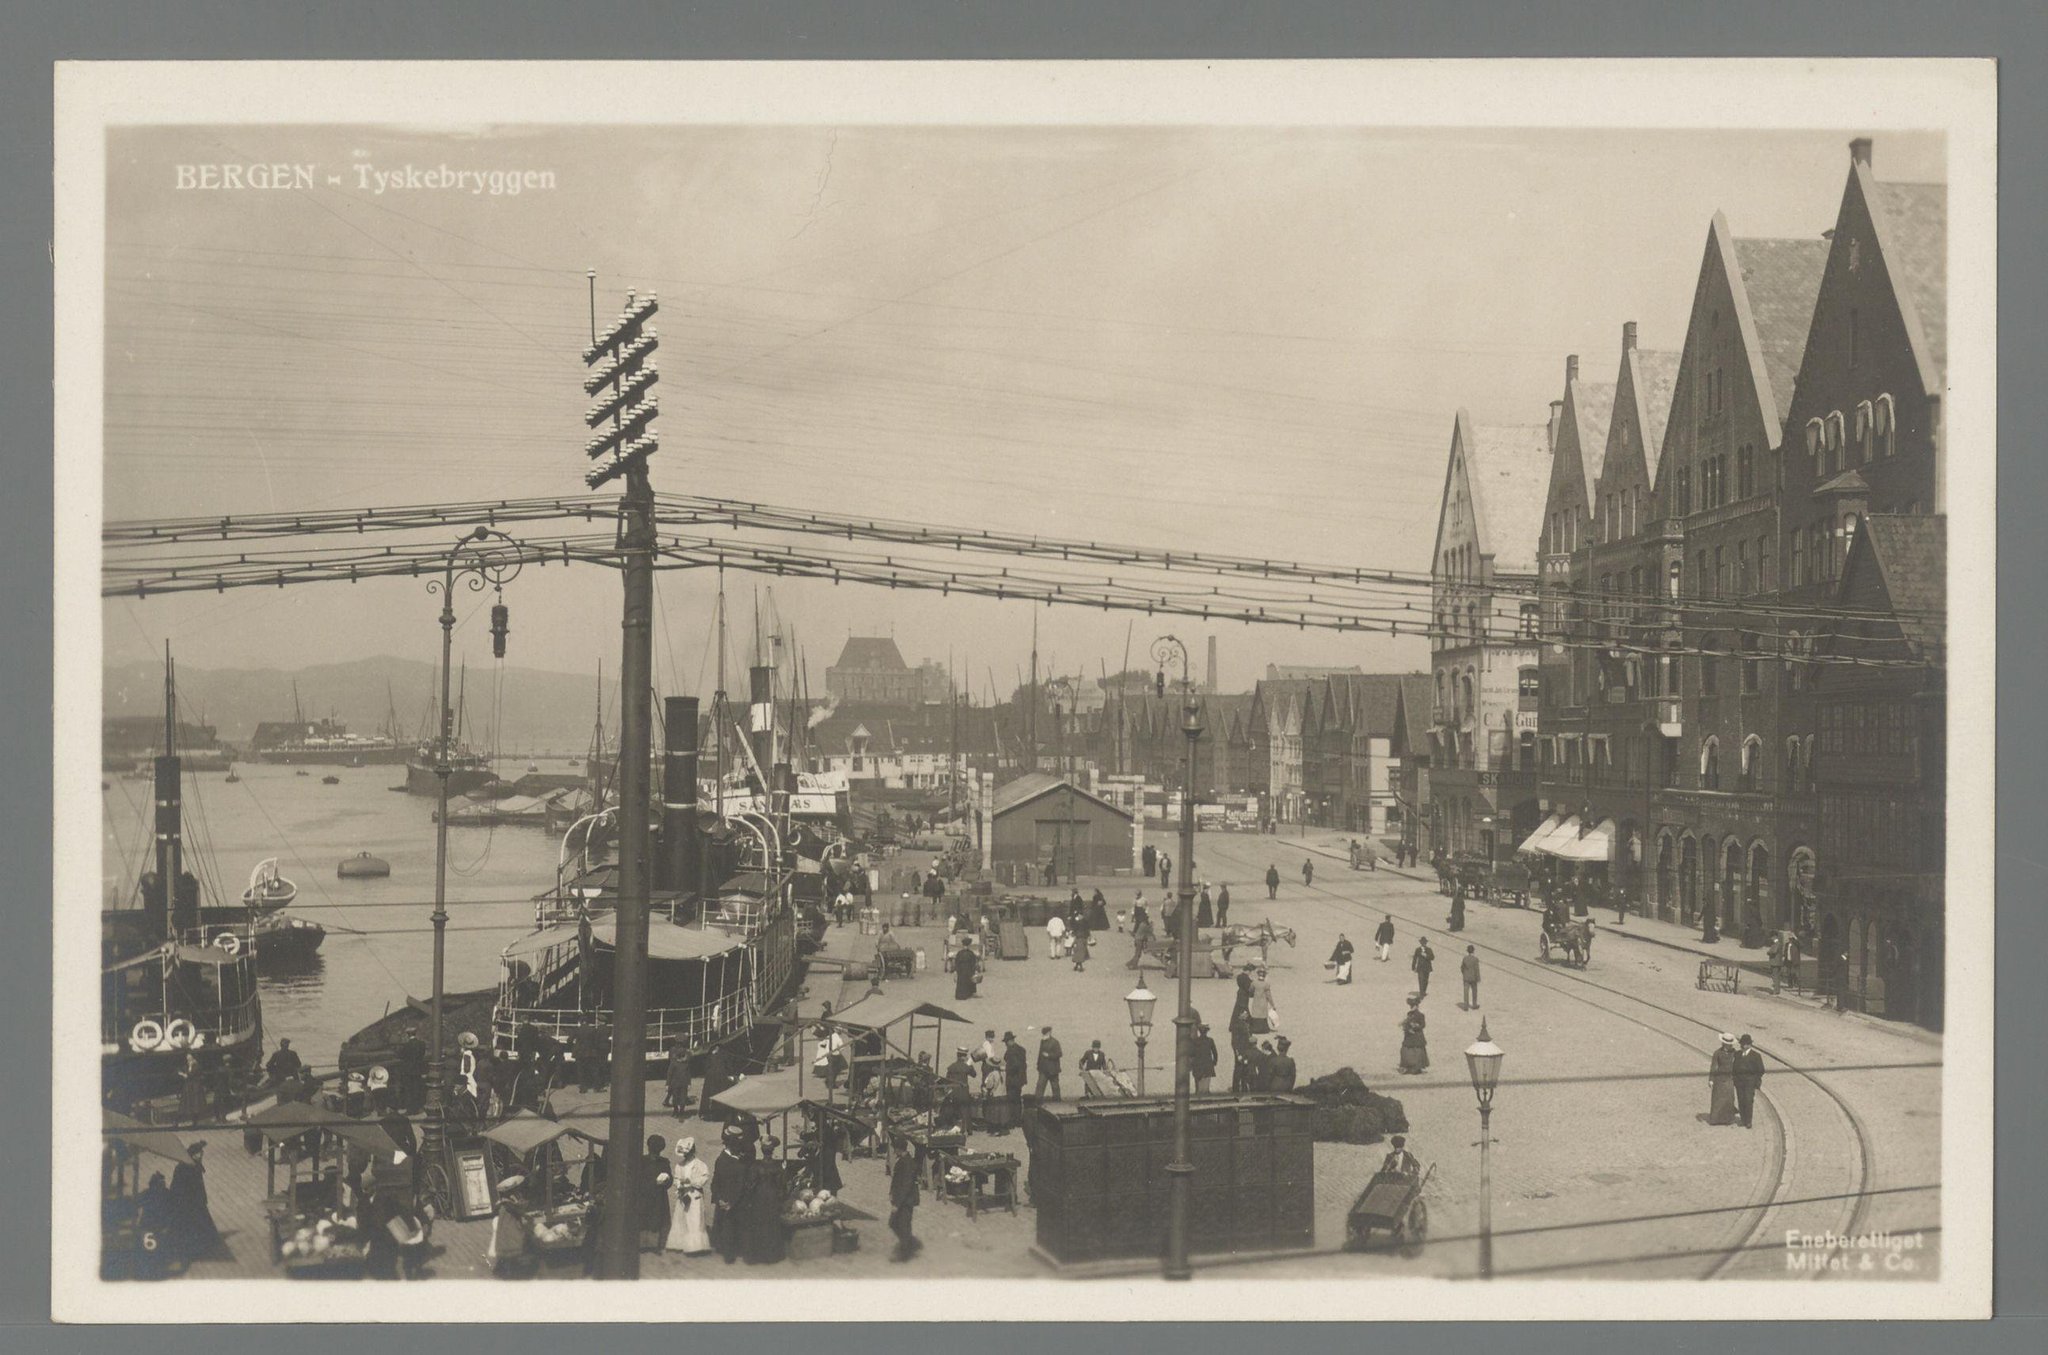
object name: ansichtkaart, prentbriefkaart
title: Bergen - Tyskebryggen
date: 1904-1930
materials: paper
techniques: gelatin silver print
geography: bergen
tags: harbour, street